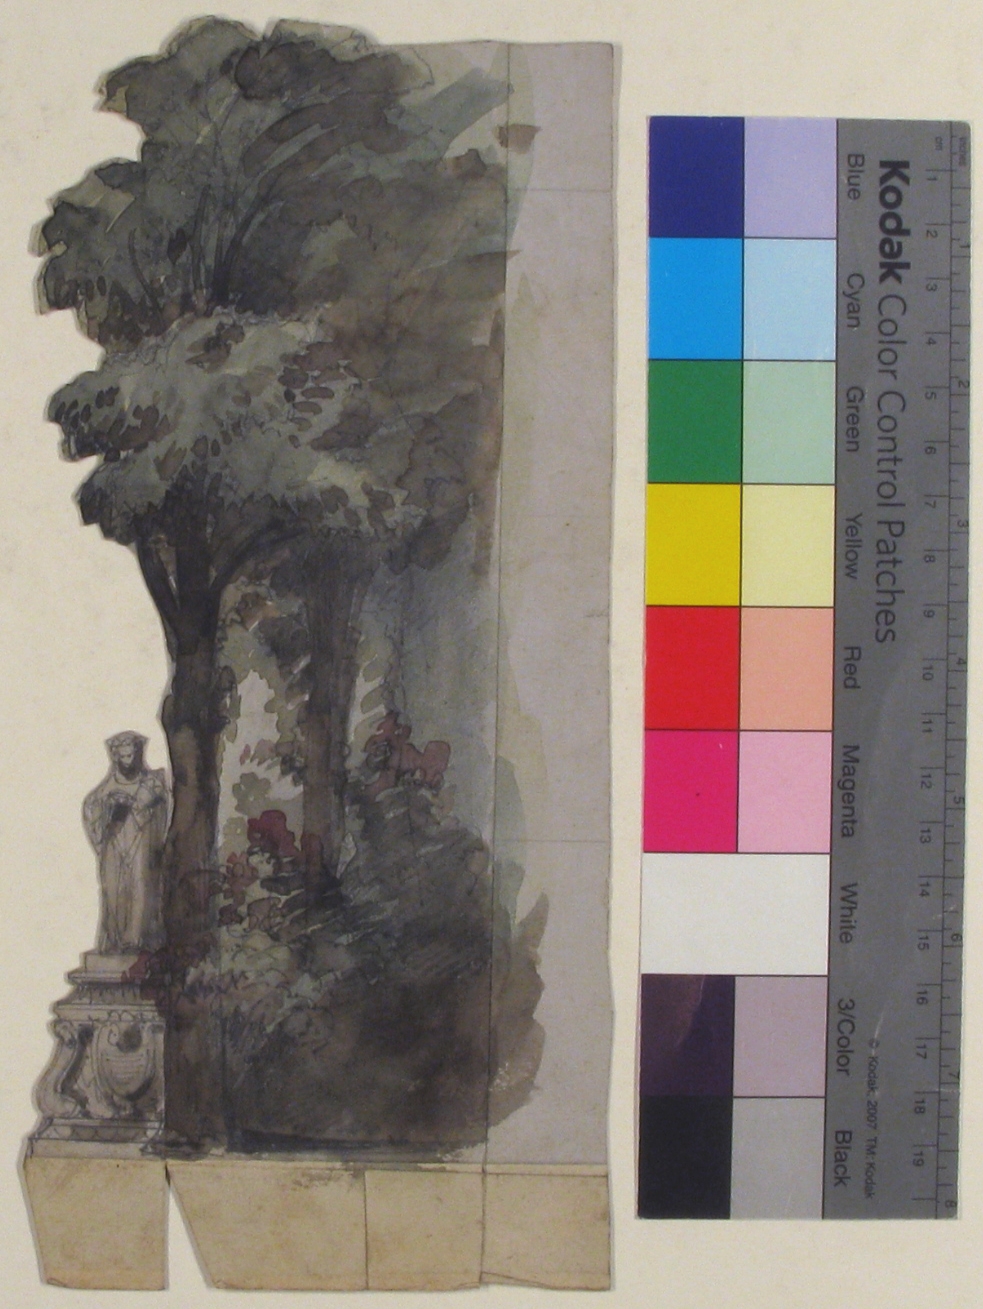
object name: drawing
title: Design for a Stage Set at the Opéra, Paris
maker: eugène cicéri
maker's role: artist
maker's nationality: french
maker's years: 1813-1890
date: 1830-1890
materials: graphite, watercolor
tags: trees,stage design